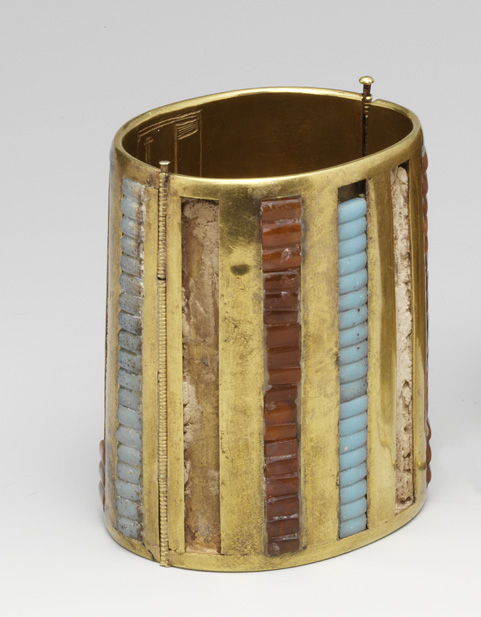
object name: bracelet, cuff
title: Hinged Cuff Bracelet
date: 1479-1425 BCE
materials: gemstone, glass, gold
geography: egypt